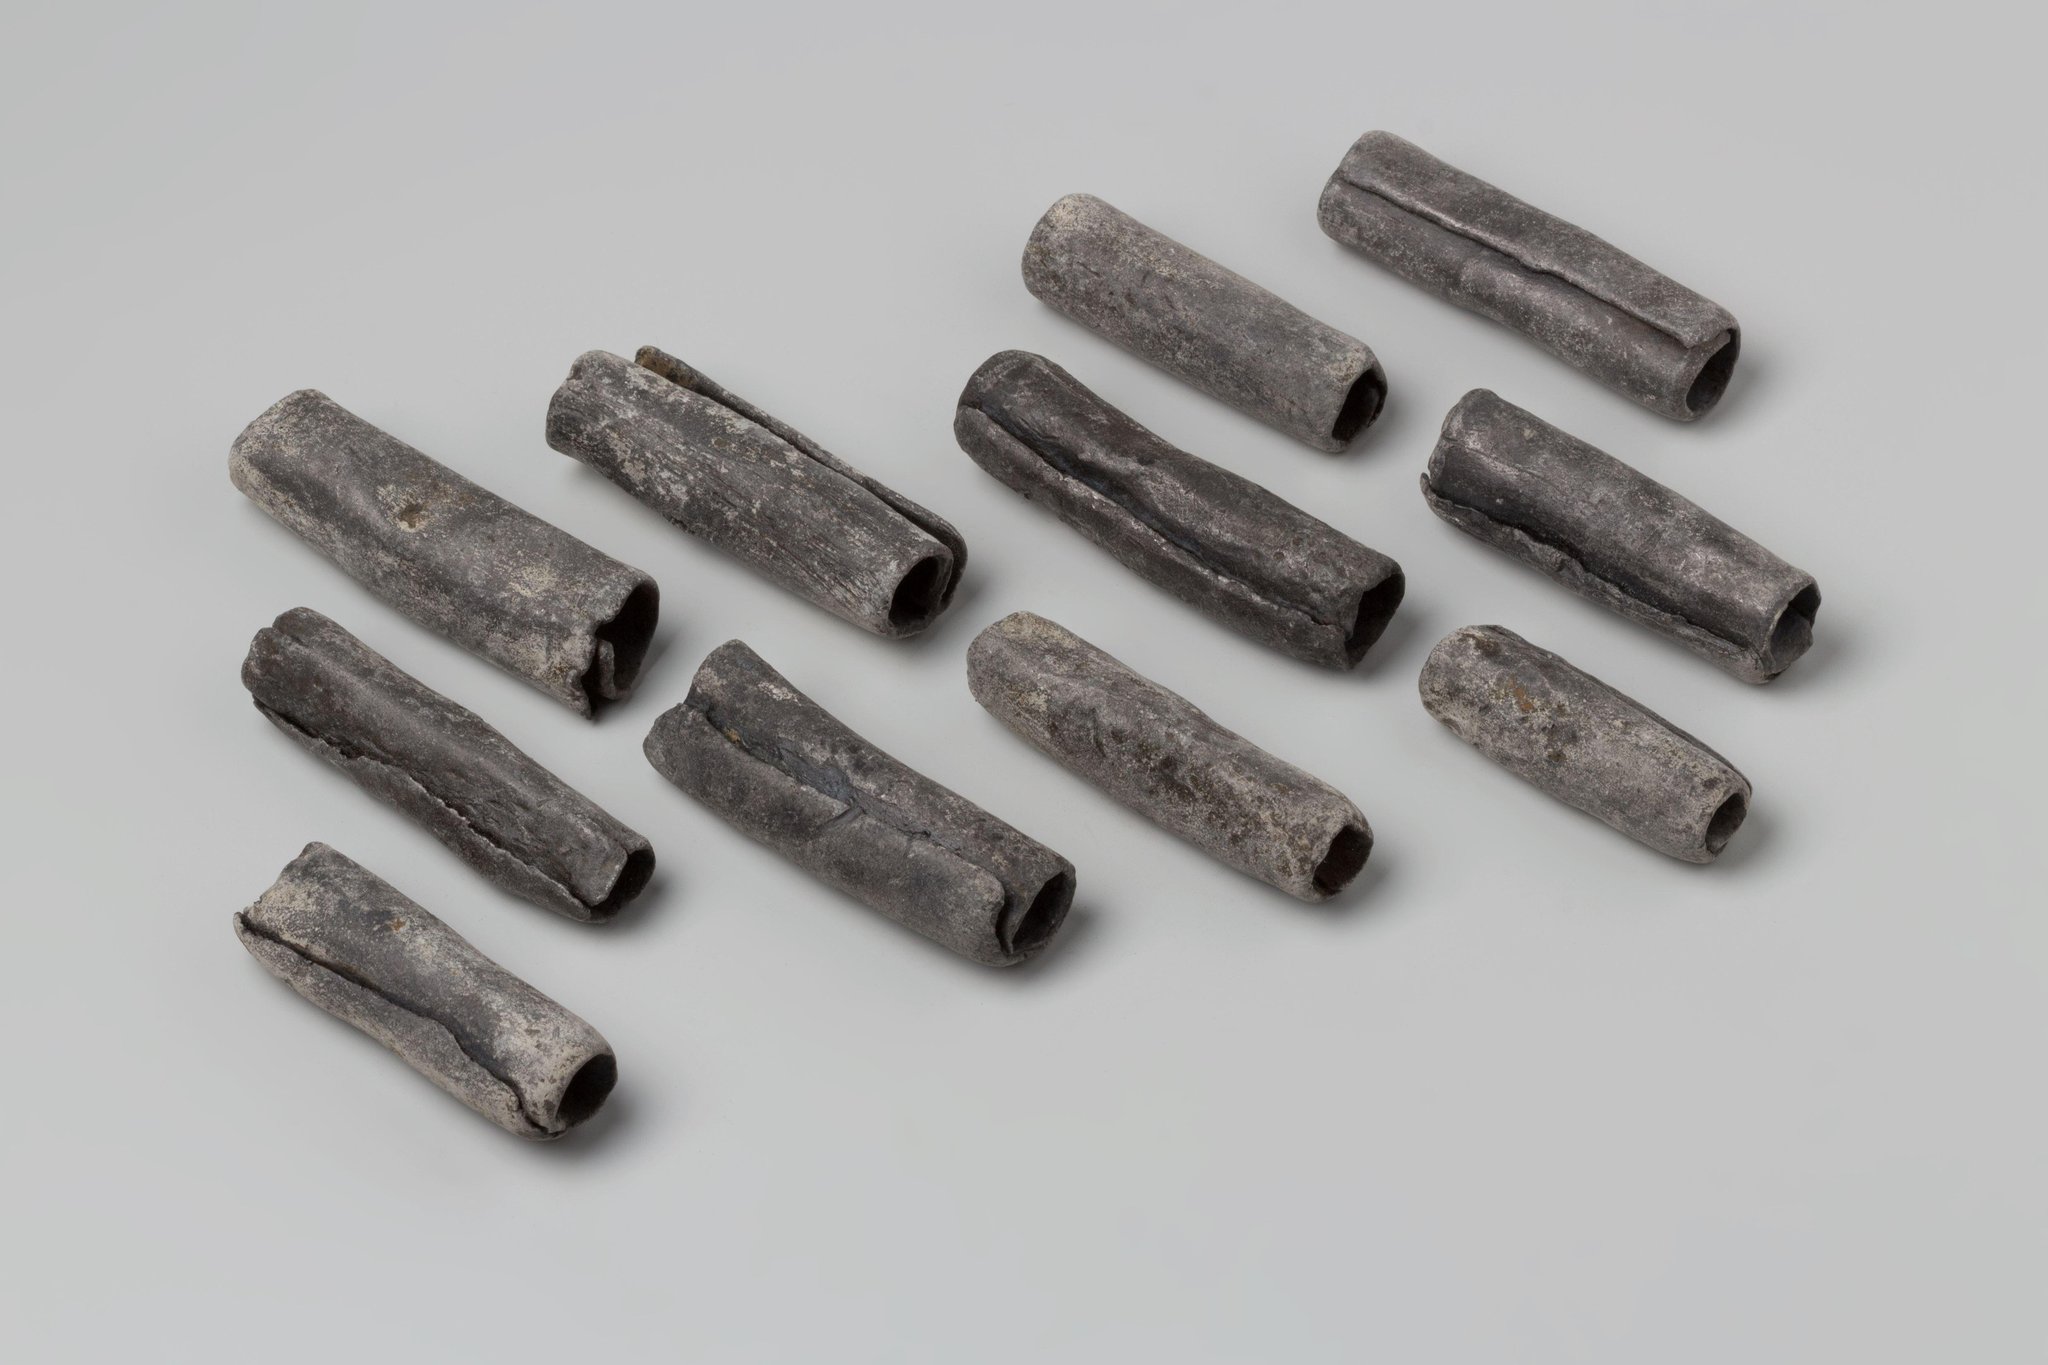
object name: lead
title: Loden rol uit het wrak van de Oost-Indiëvaarder 't Vliegend Hart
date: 1700-1735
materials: lead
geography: middelburg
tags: 't vliegend hart (schip), verenigde oostindische compagnie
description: Deze loden buisjes zijn vermoedelijk afkomstig van visnetten ofwel op TVliegend Hart zelf ofwel van vissers die hun netten aan het wrak verloren.